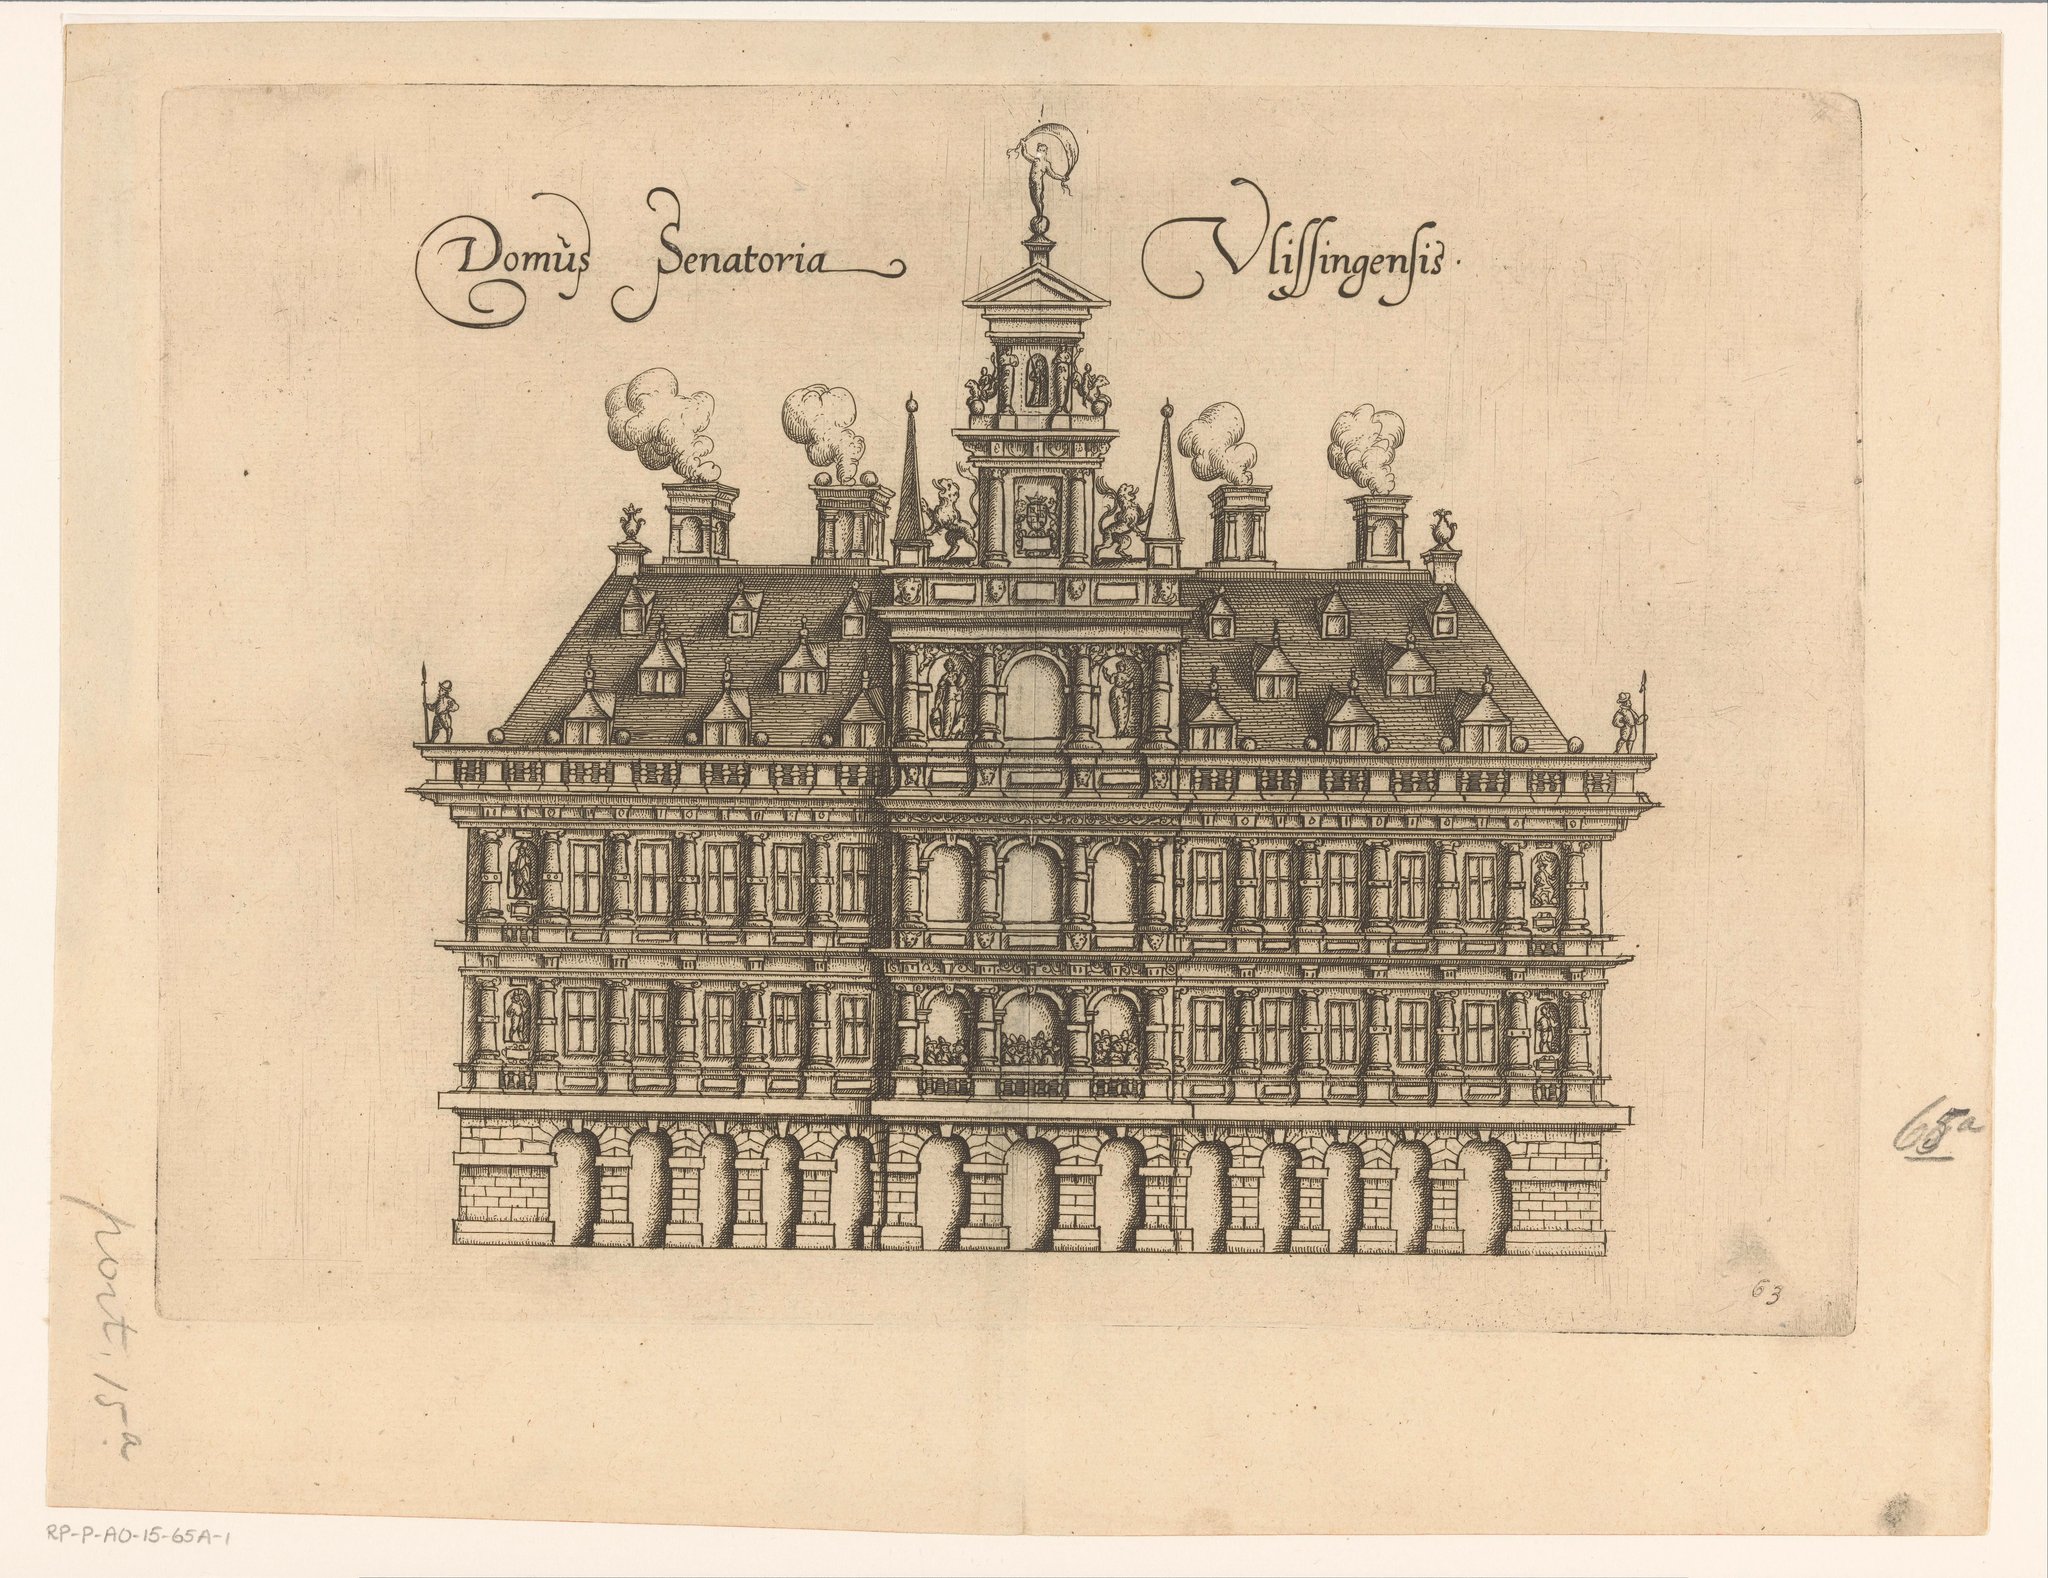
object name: book illustration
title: Domus Senatoria Vlissingensis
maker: Anonymous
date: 1612-1648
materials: paper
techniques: etching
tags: townhall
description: Deze staat van prent voor het eerst ook gebruikt in: Guicciardini, Lodovico. Beschryvinghe van alle de Neder-landen, anderssins ghenoemt Neder-Duytslandt (…). Amsterdam: Willem Janszoon Blaeu, 1612. Hierna is deze prent tot 1648 nog gebruikt in latere uitgaven van deze publicatie, uitgegeven door Blaeu en daarna door Janssonius. Uit welke uitgave het huidige exemplaar precies komt is niet na te gaan.